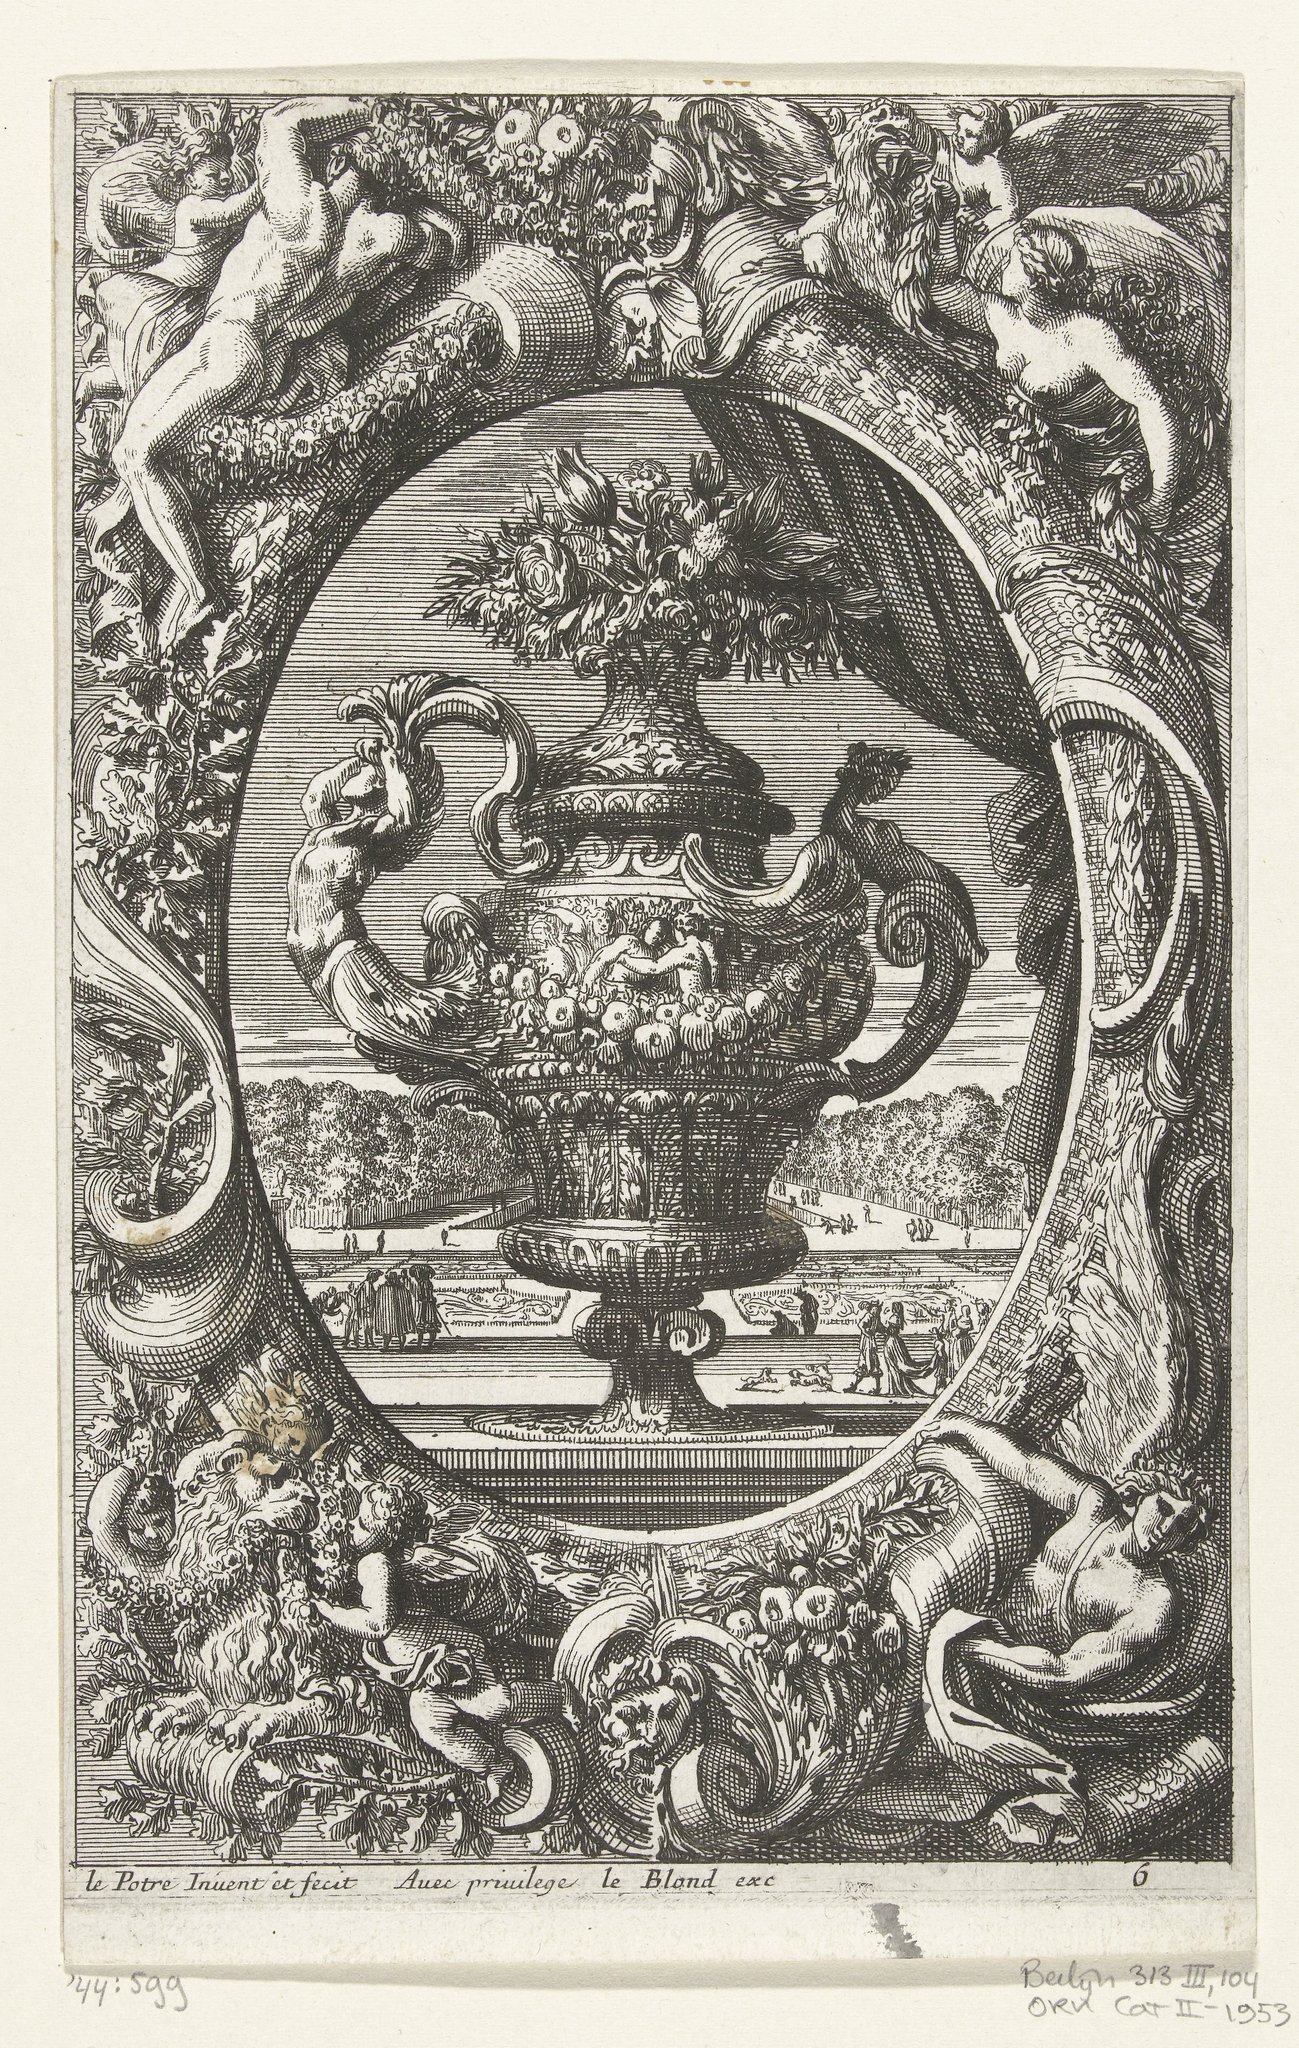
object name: ornament print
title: Vaas in cartouche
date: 1650-1664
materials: paper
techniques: etching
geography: france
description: Vaas met boeket bloemen in ovale lijst met een variant voor de rechterhelft. Uit tweede editie.